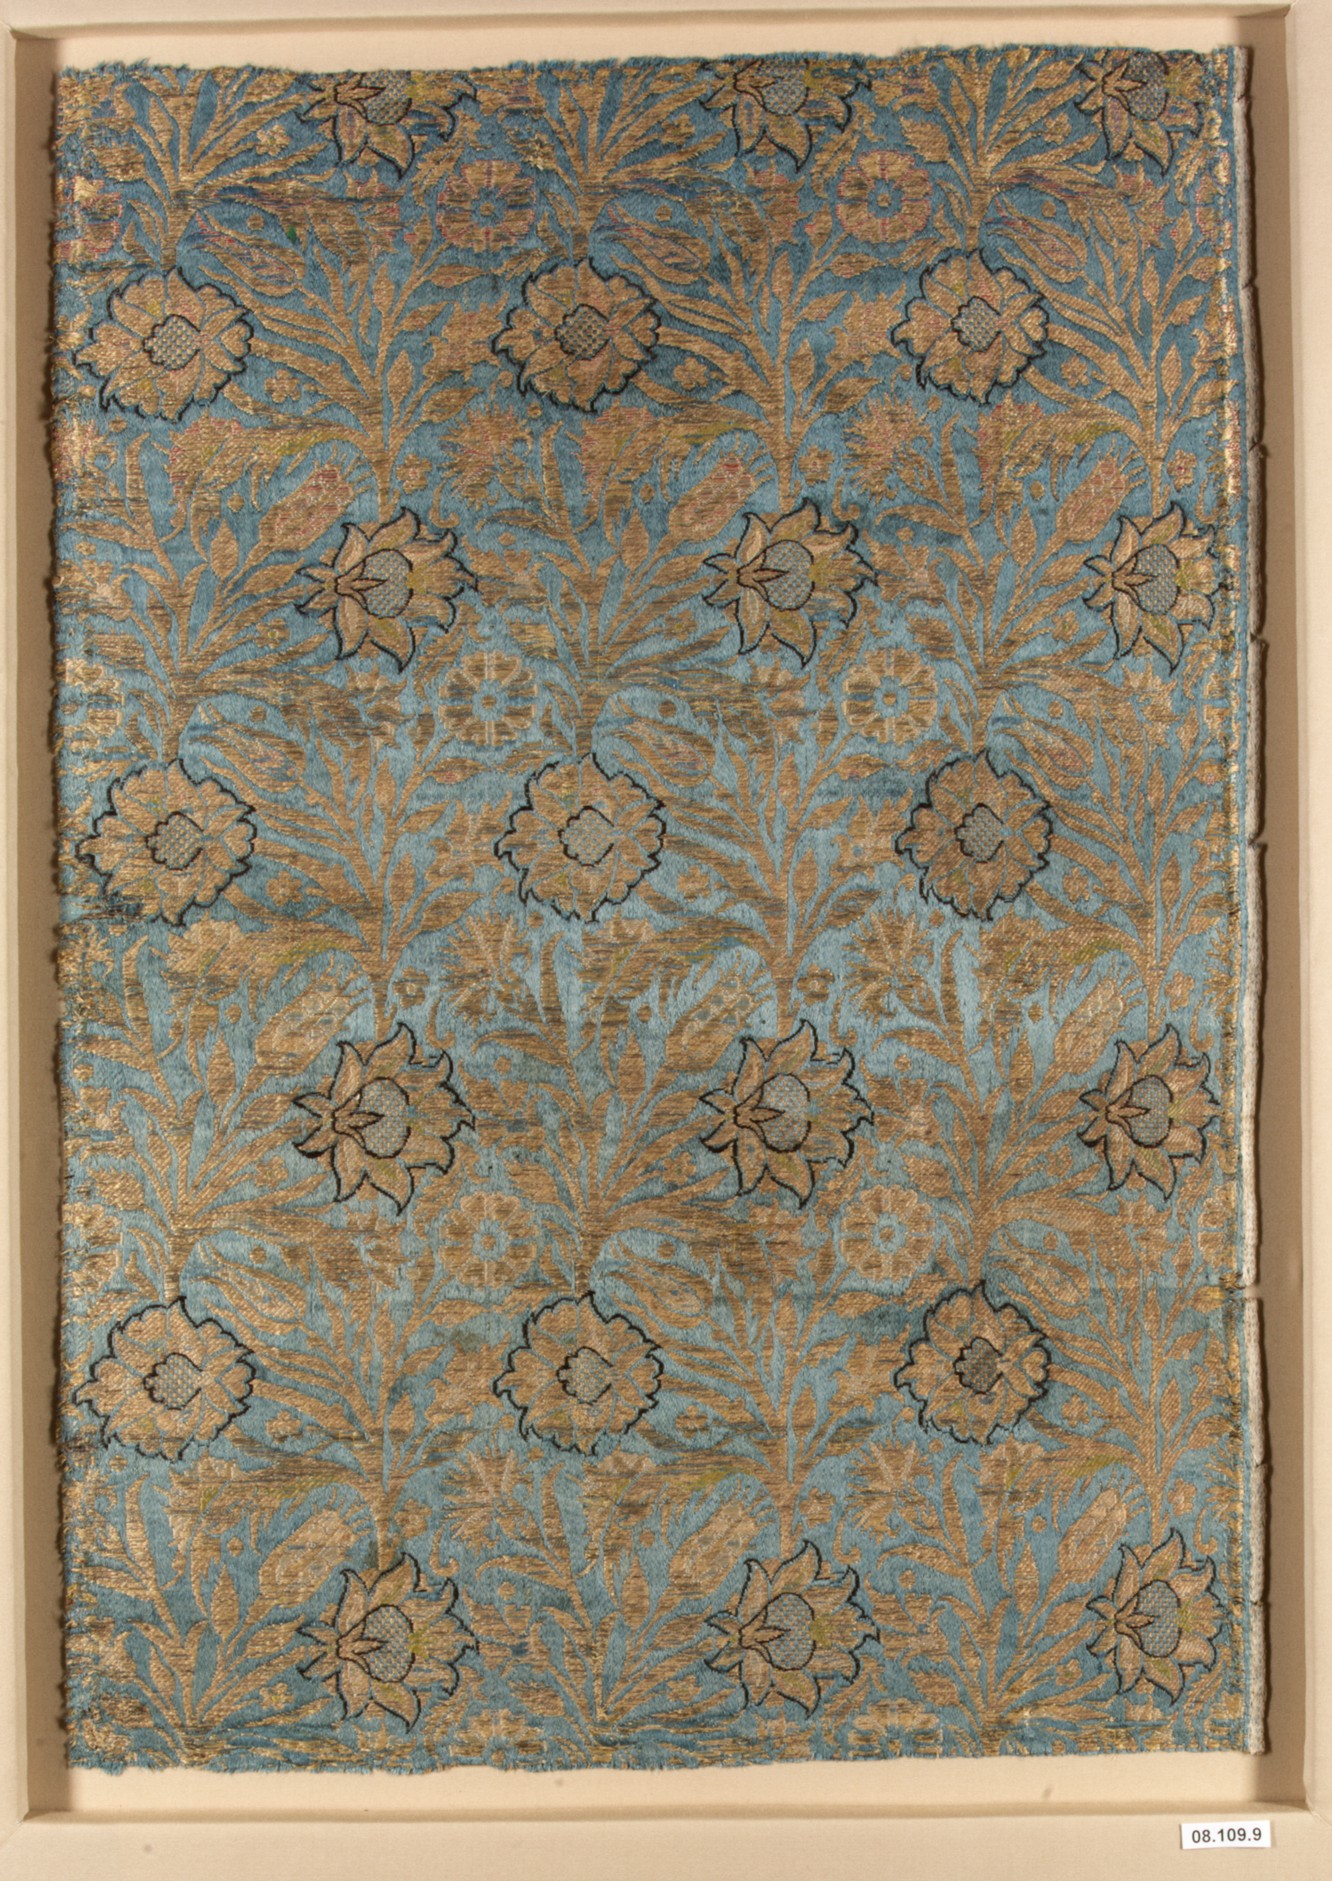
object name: textile fragment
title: Fragment of a Brocaded Silk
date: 1601-1700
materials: metal thread, silk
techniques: brocade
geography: turkey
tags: flowers